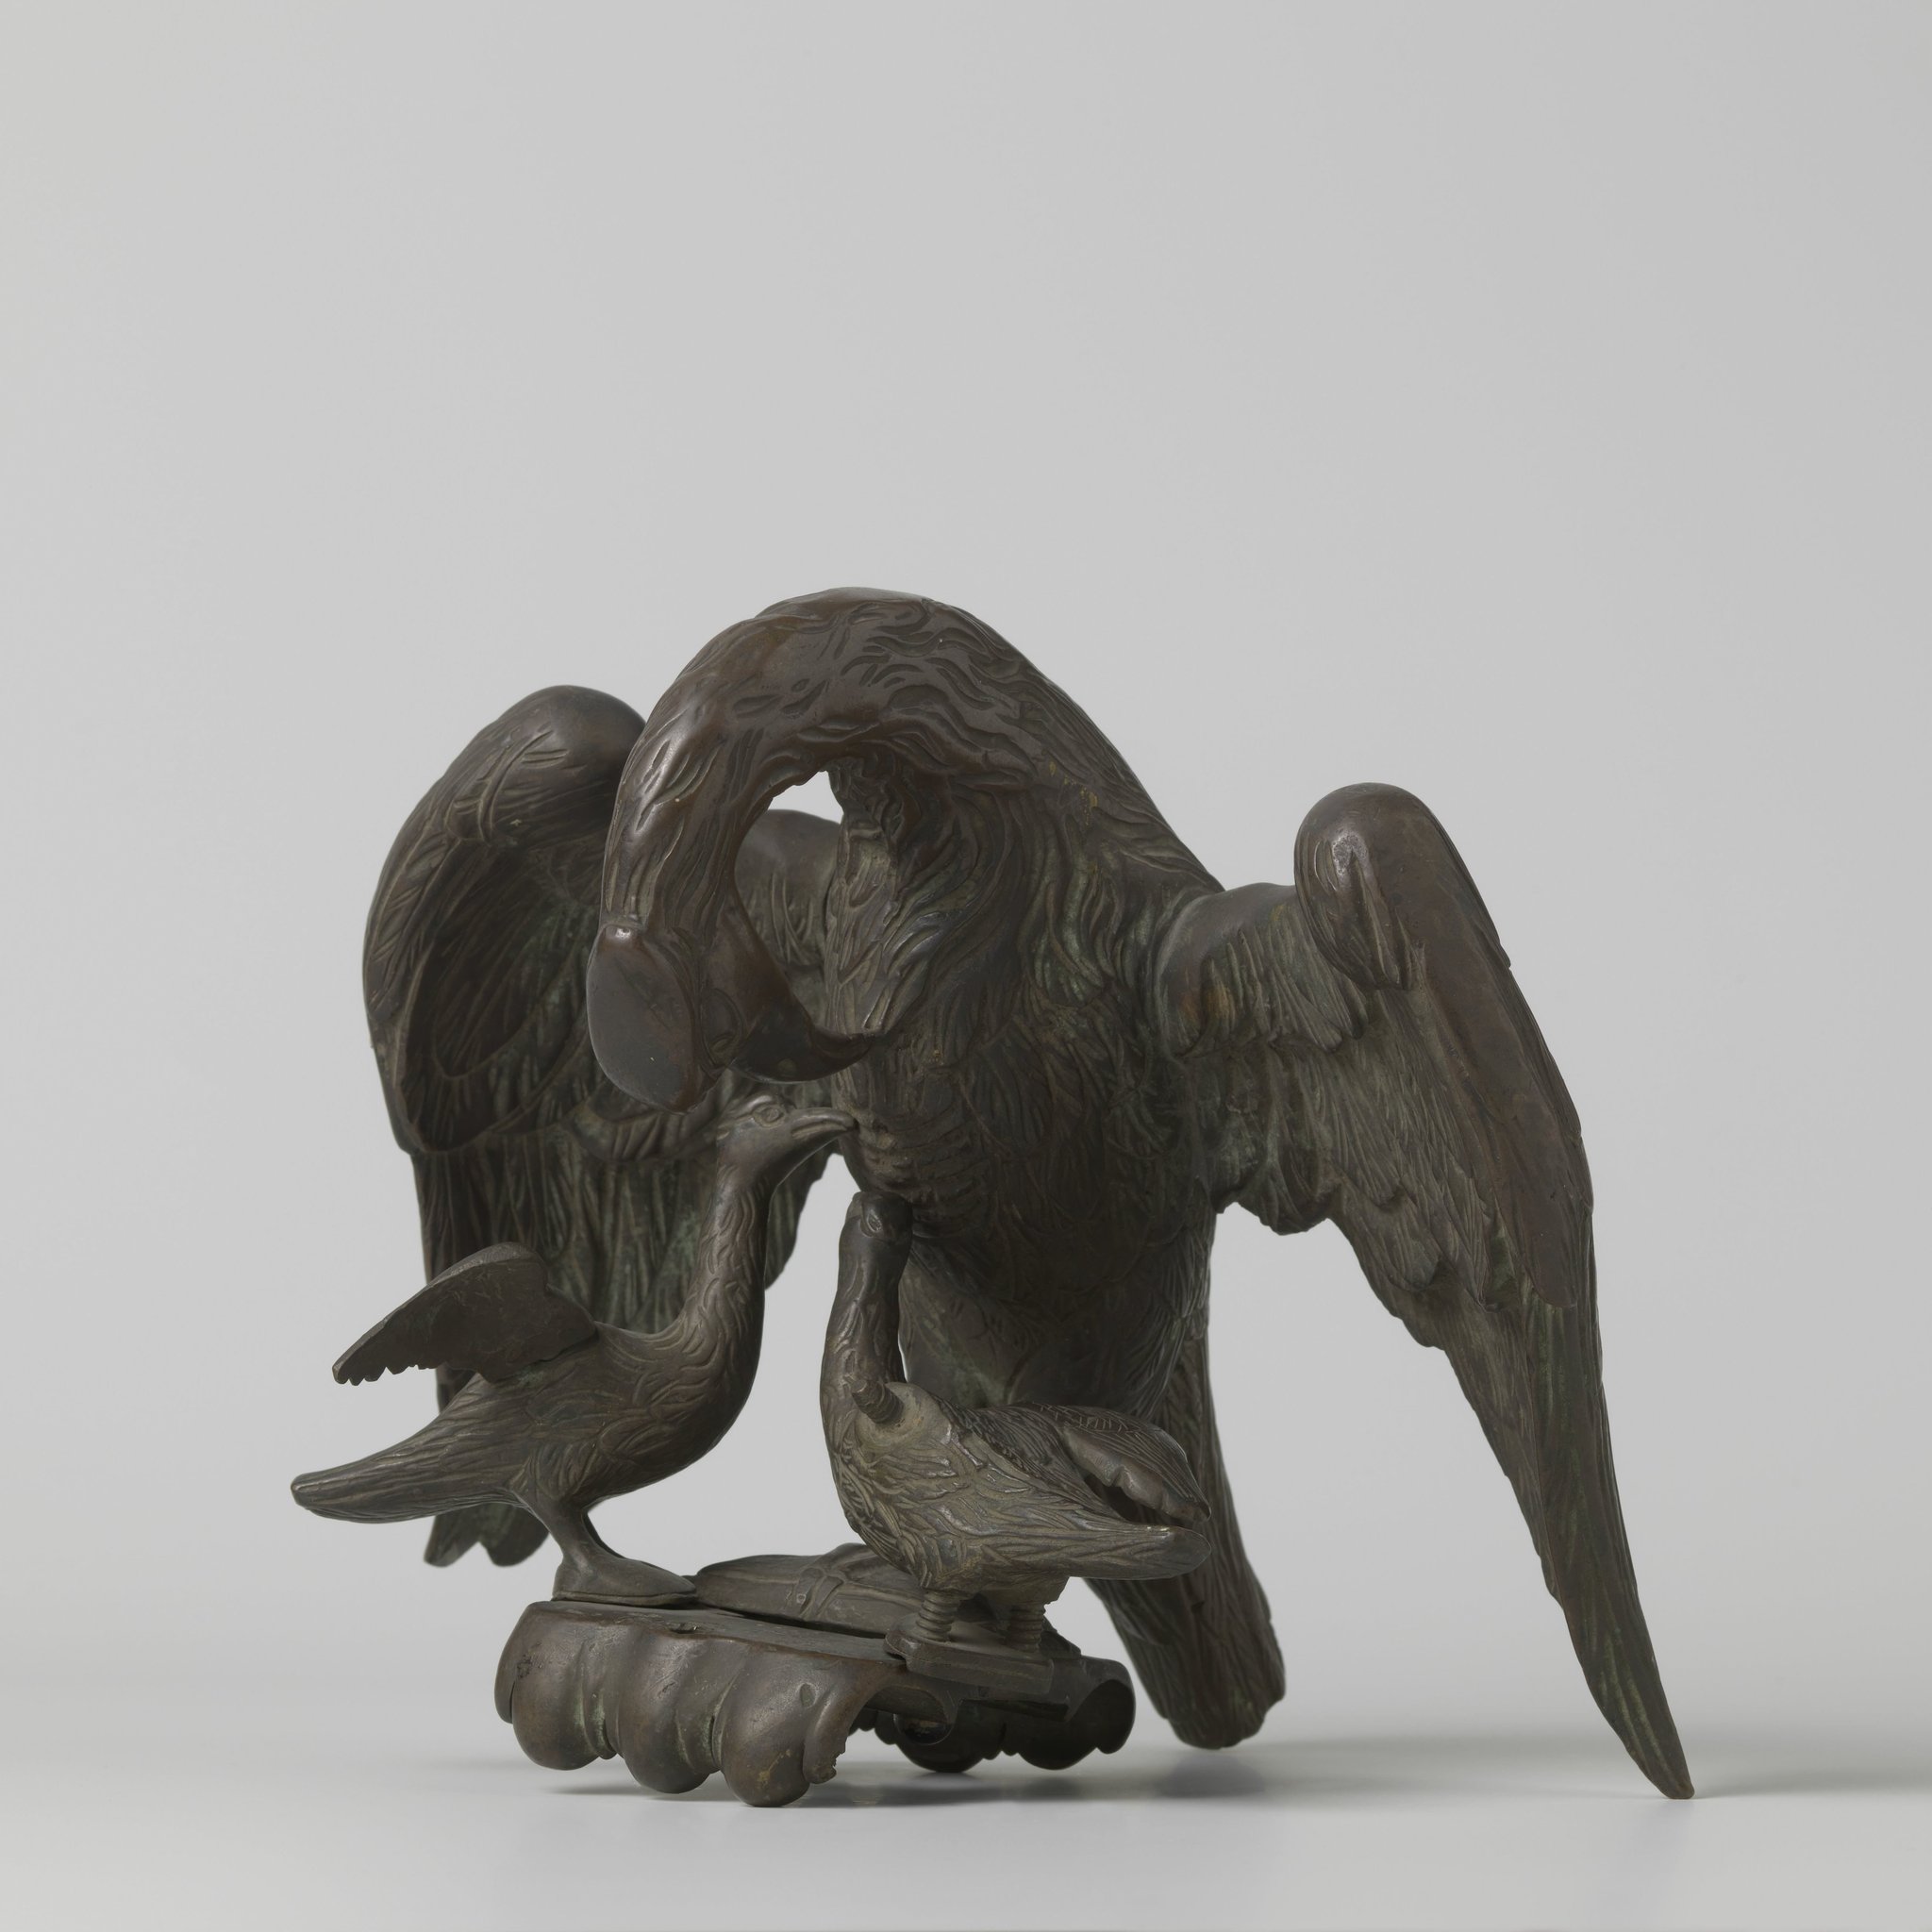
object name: figure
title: Pelikanenjong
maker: Anonymous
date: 1750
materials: brass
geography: netherlands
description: Beeld van een pelikanenjong. Betreft een groep van pelikaan met twee jongen, zie ook BK-NM-9443-a en c. De groep symboliseert het Christelijk geloof.